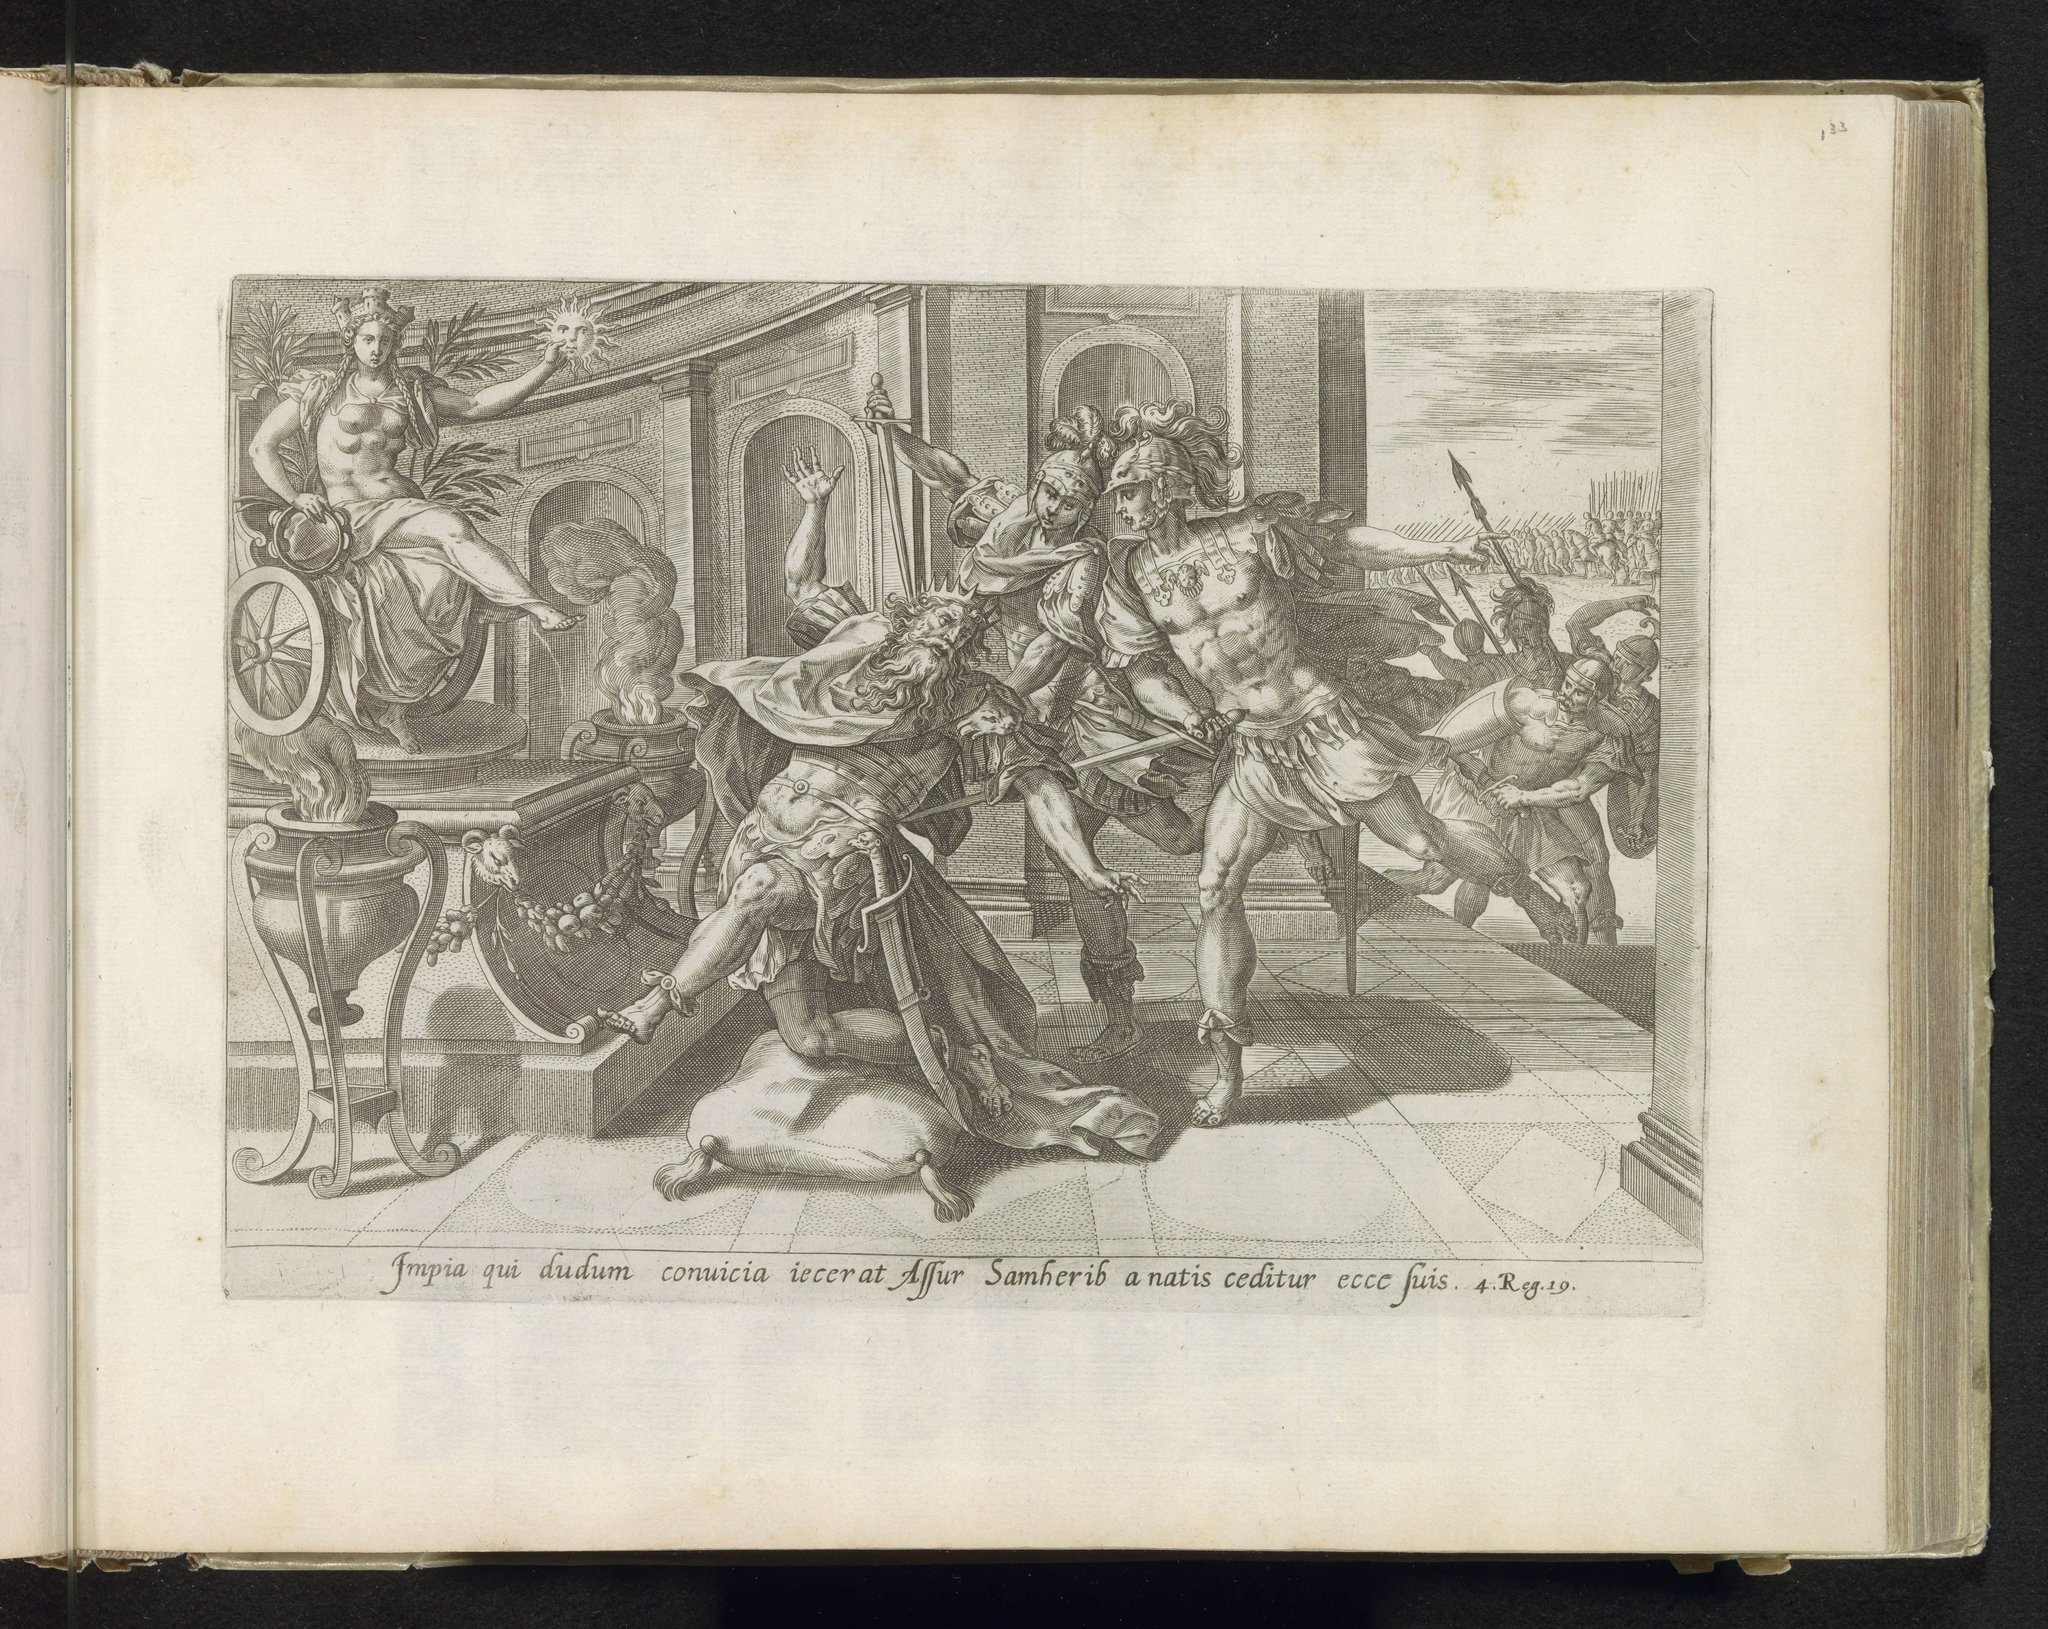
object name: album leaf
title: Geschiedenis van Hizkia en Sanherib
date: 1585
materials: paper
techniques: engraving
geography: antwerp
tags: when sennacherib is worshipping in the temple, two of his sons kill him with their swords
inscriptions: inscription: ‘V. 4.’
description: Terwijl Koning Sanherib van Assyrië neerknielt in de tempel van zijn god Nisroch, wordt hij vermoord door twee van zijn zonen. Onder de voorstelling een verwijzing in het Latijn naar de Bijbeltekst in 2 Kon. 19. Deze prent maakt deel uit van een album.